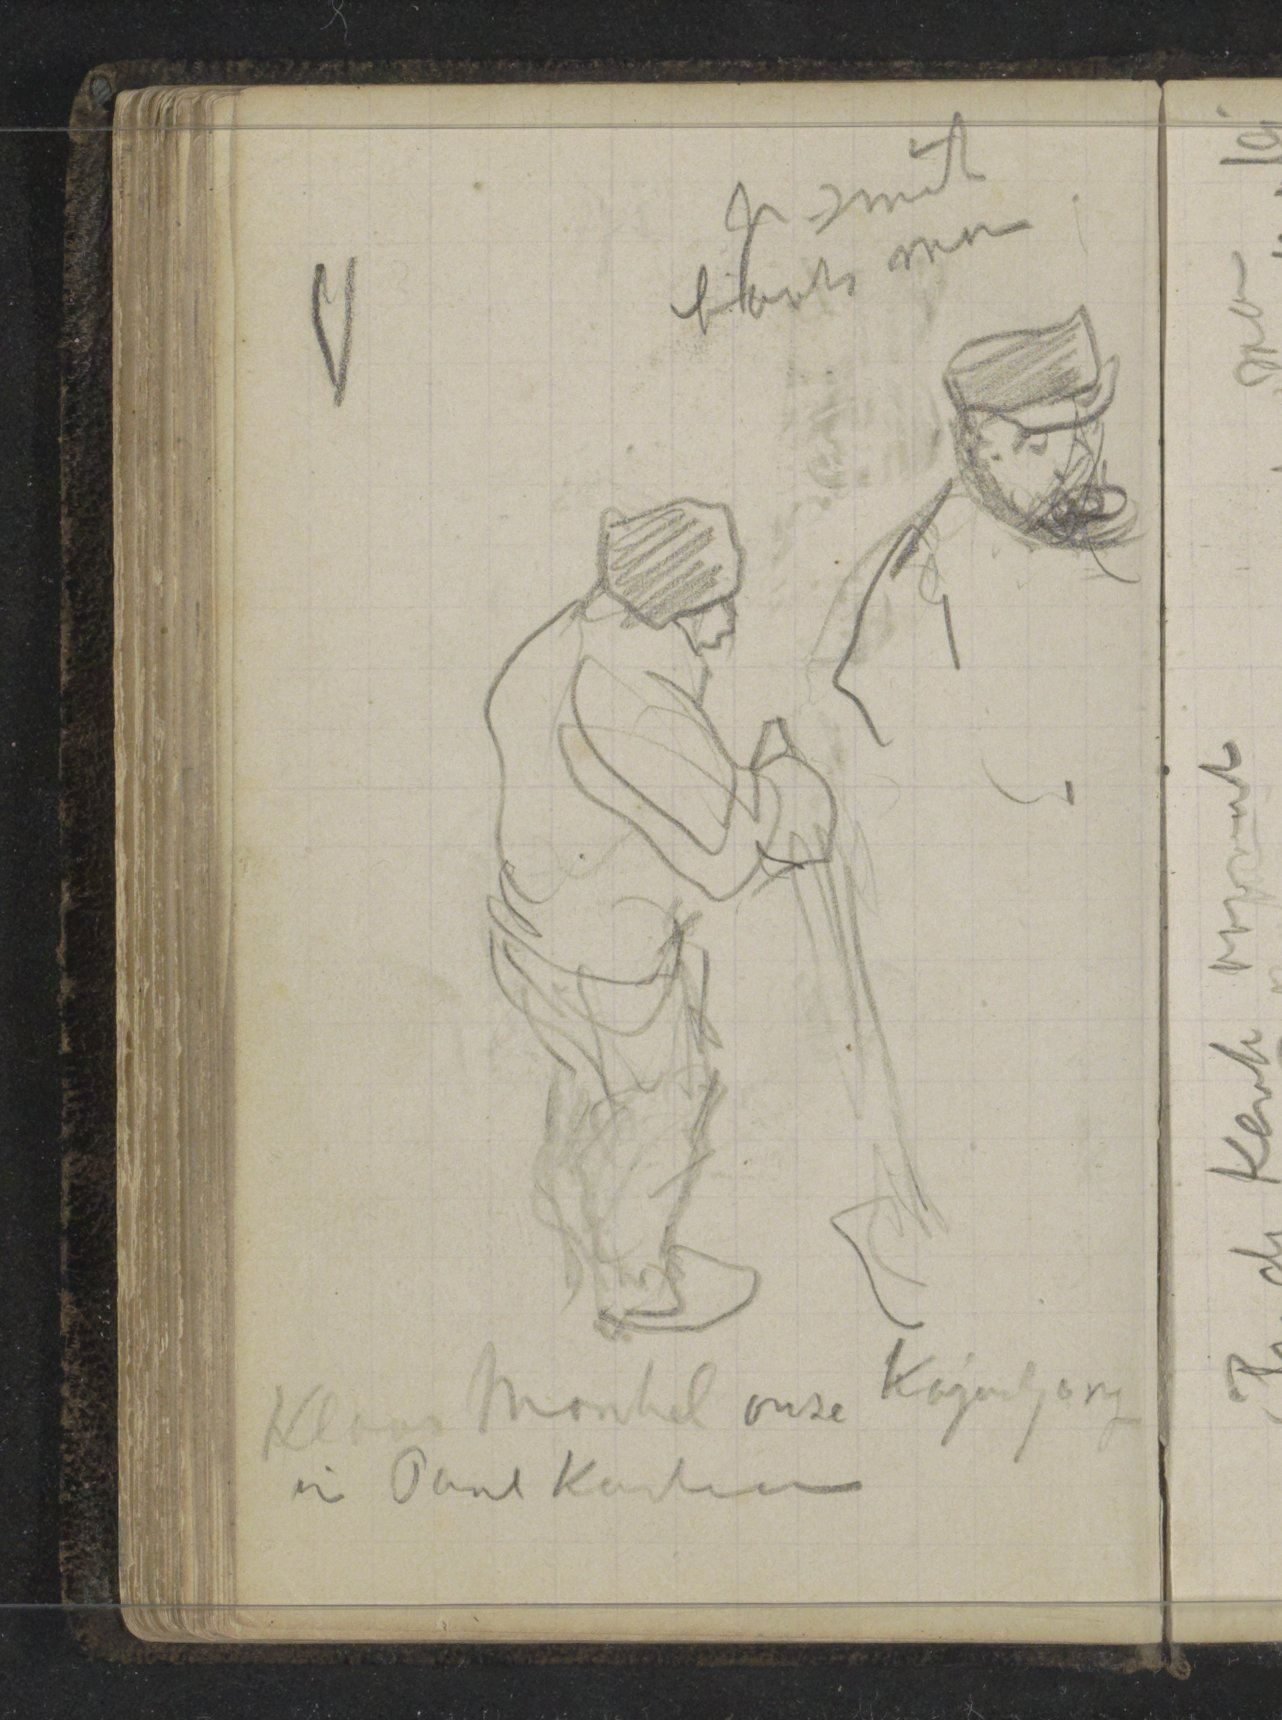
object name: sketchbook leaf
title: Twee bemanningsleden van de Willem Barentsz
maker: louis apol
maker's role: draughtsman, painter, print maker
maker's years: 1850-1936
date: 1809-1880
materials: pencil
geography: hammerfest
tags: crew ~ ship, agricultural implements: spade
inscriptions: annotation: ‘G Smit [?] / bootsman / Klaas Mantel onze kajuitjongen / [...]’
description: Links scheepsjongen Klaas Mantel met een schop. Rechts bootsman Smit. Blad 47 verso uit een schetsboek met 110 bladen betekend tijdens de expeditie naar Nova Zembla in 1880.